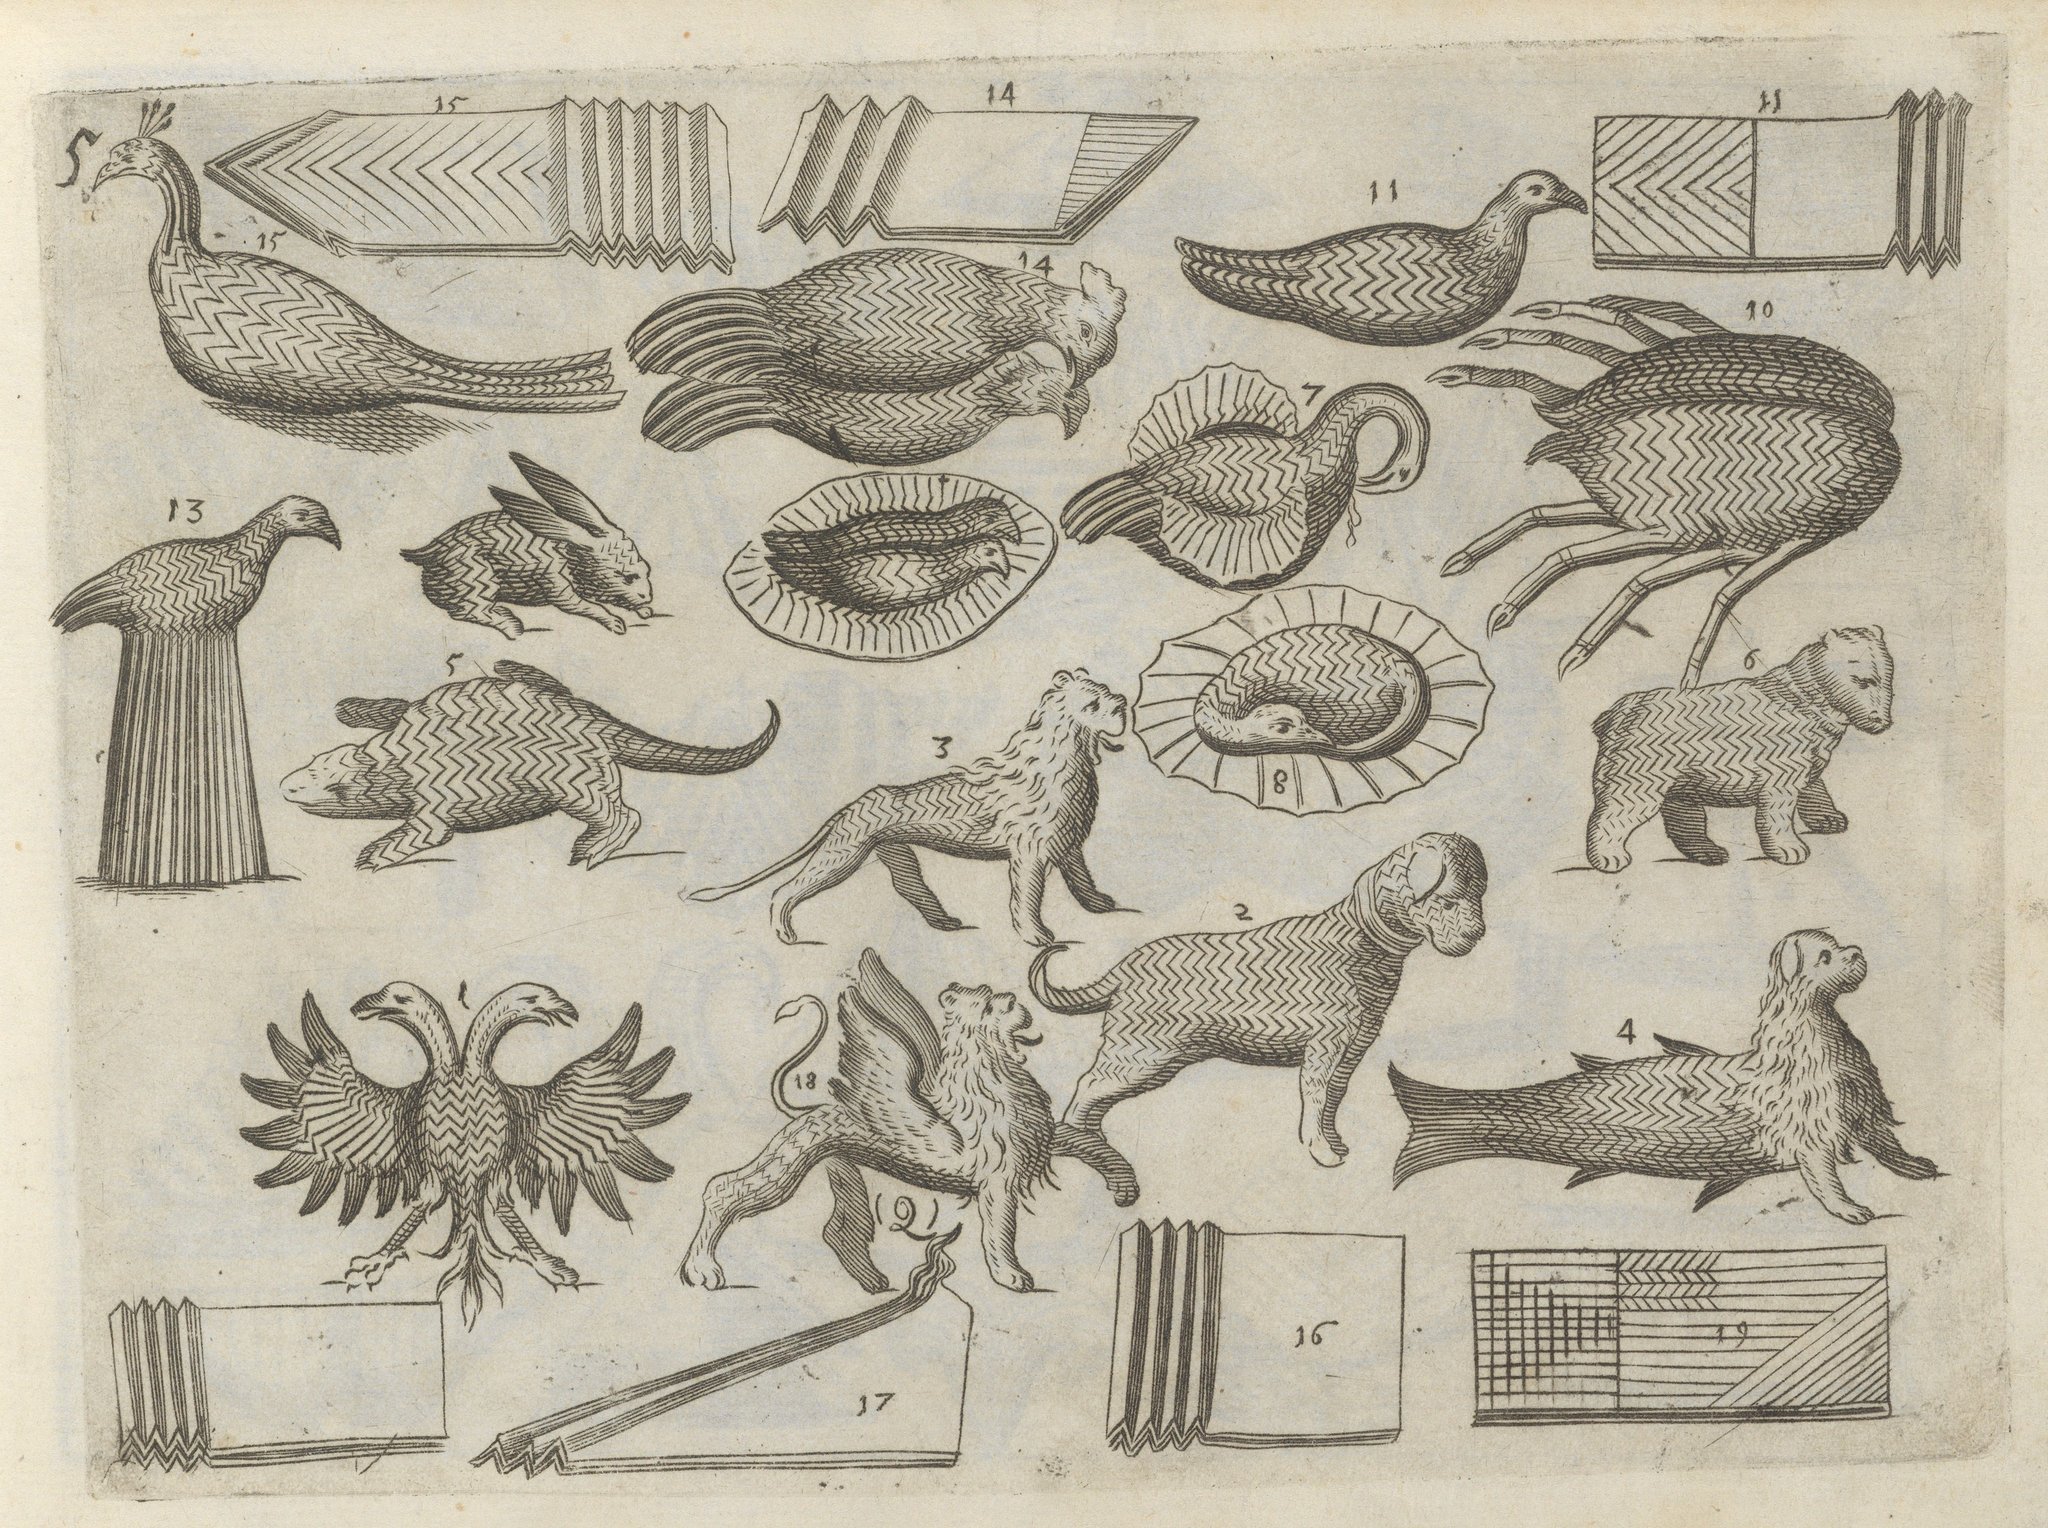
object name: book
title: Li Tre Trattai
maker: mattia giegher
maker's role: author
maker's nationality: italian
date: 1639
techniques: engraving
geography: italy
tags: animals,birds,dogs,rabbits